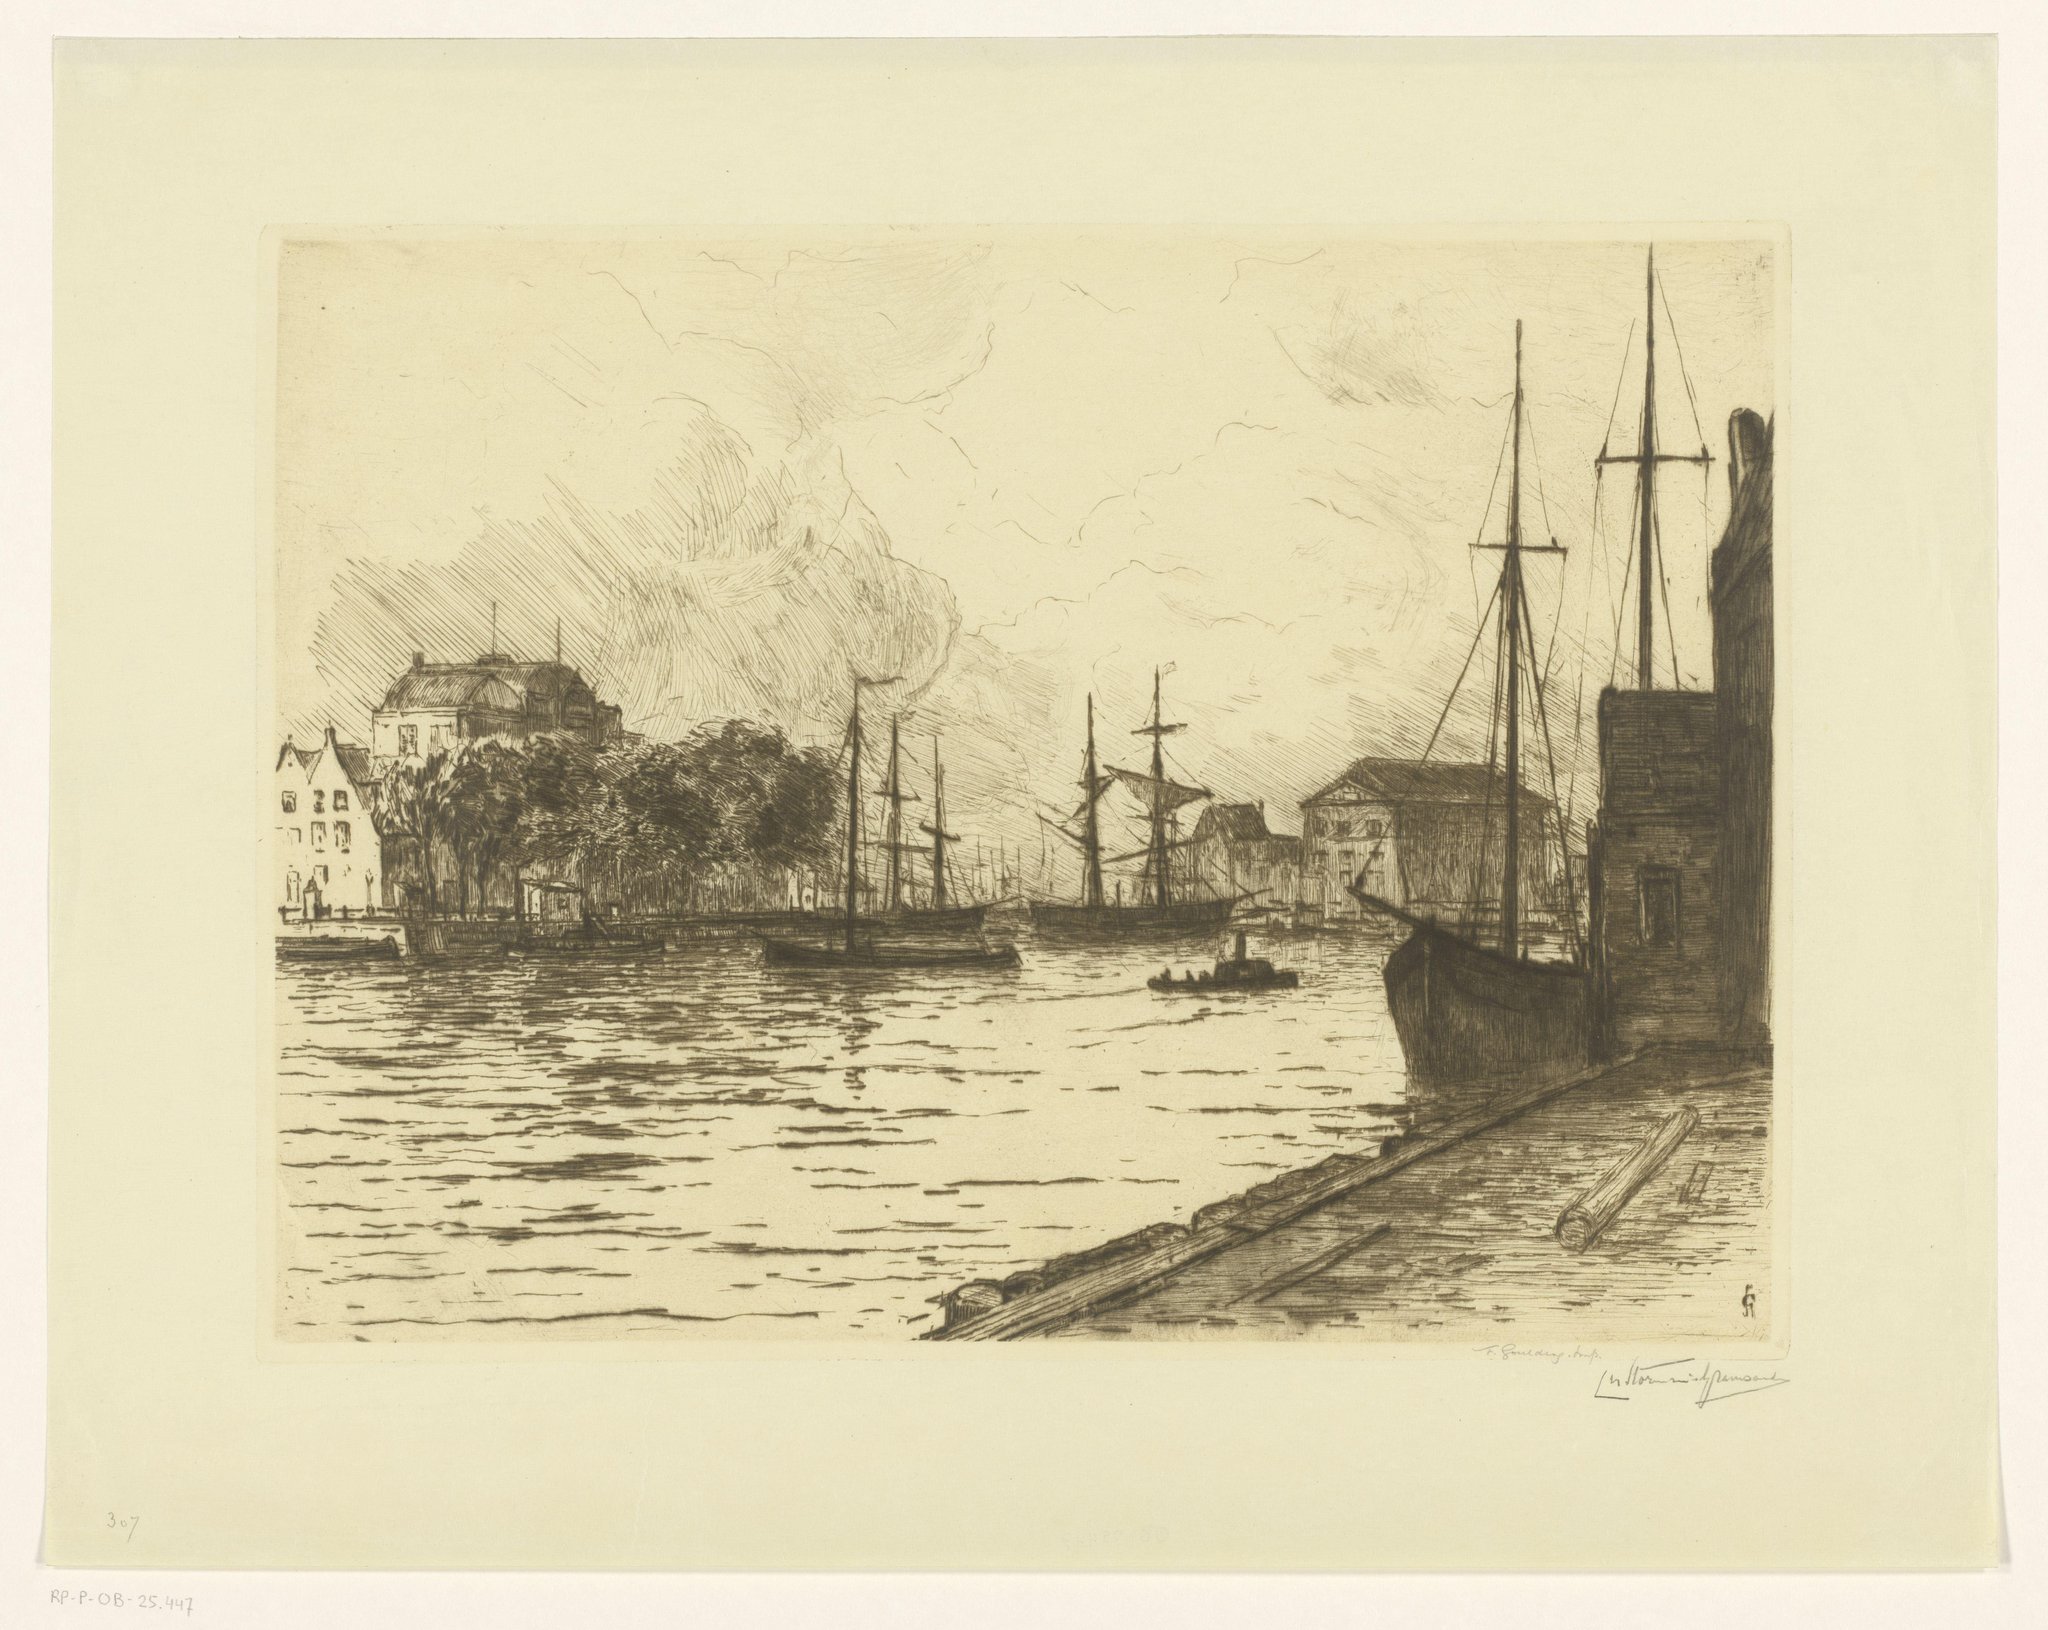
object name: print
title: Havengezicht met stadhuis in Vlissingen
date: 1887-1902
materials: paper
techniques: drypoint, intaglio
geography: netherlands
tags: harbour, townhall, flushing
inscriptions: number: ‘307’, collector's mark: Lugt 2228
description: Mogelijk vermeld in: Storm van 's-Gravesande, Charles. Catalogue des eaux-fortes et lithographies. New York: s.n., 1903, of in een onbekende latere uitgave van het manuscript. Vermoedelijk vermeld als catalogusnummer 307.